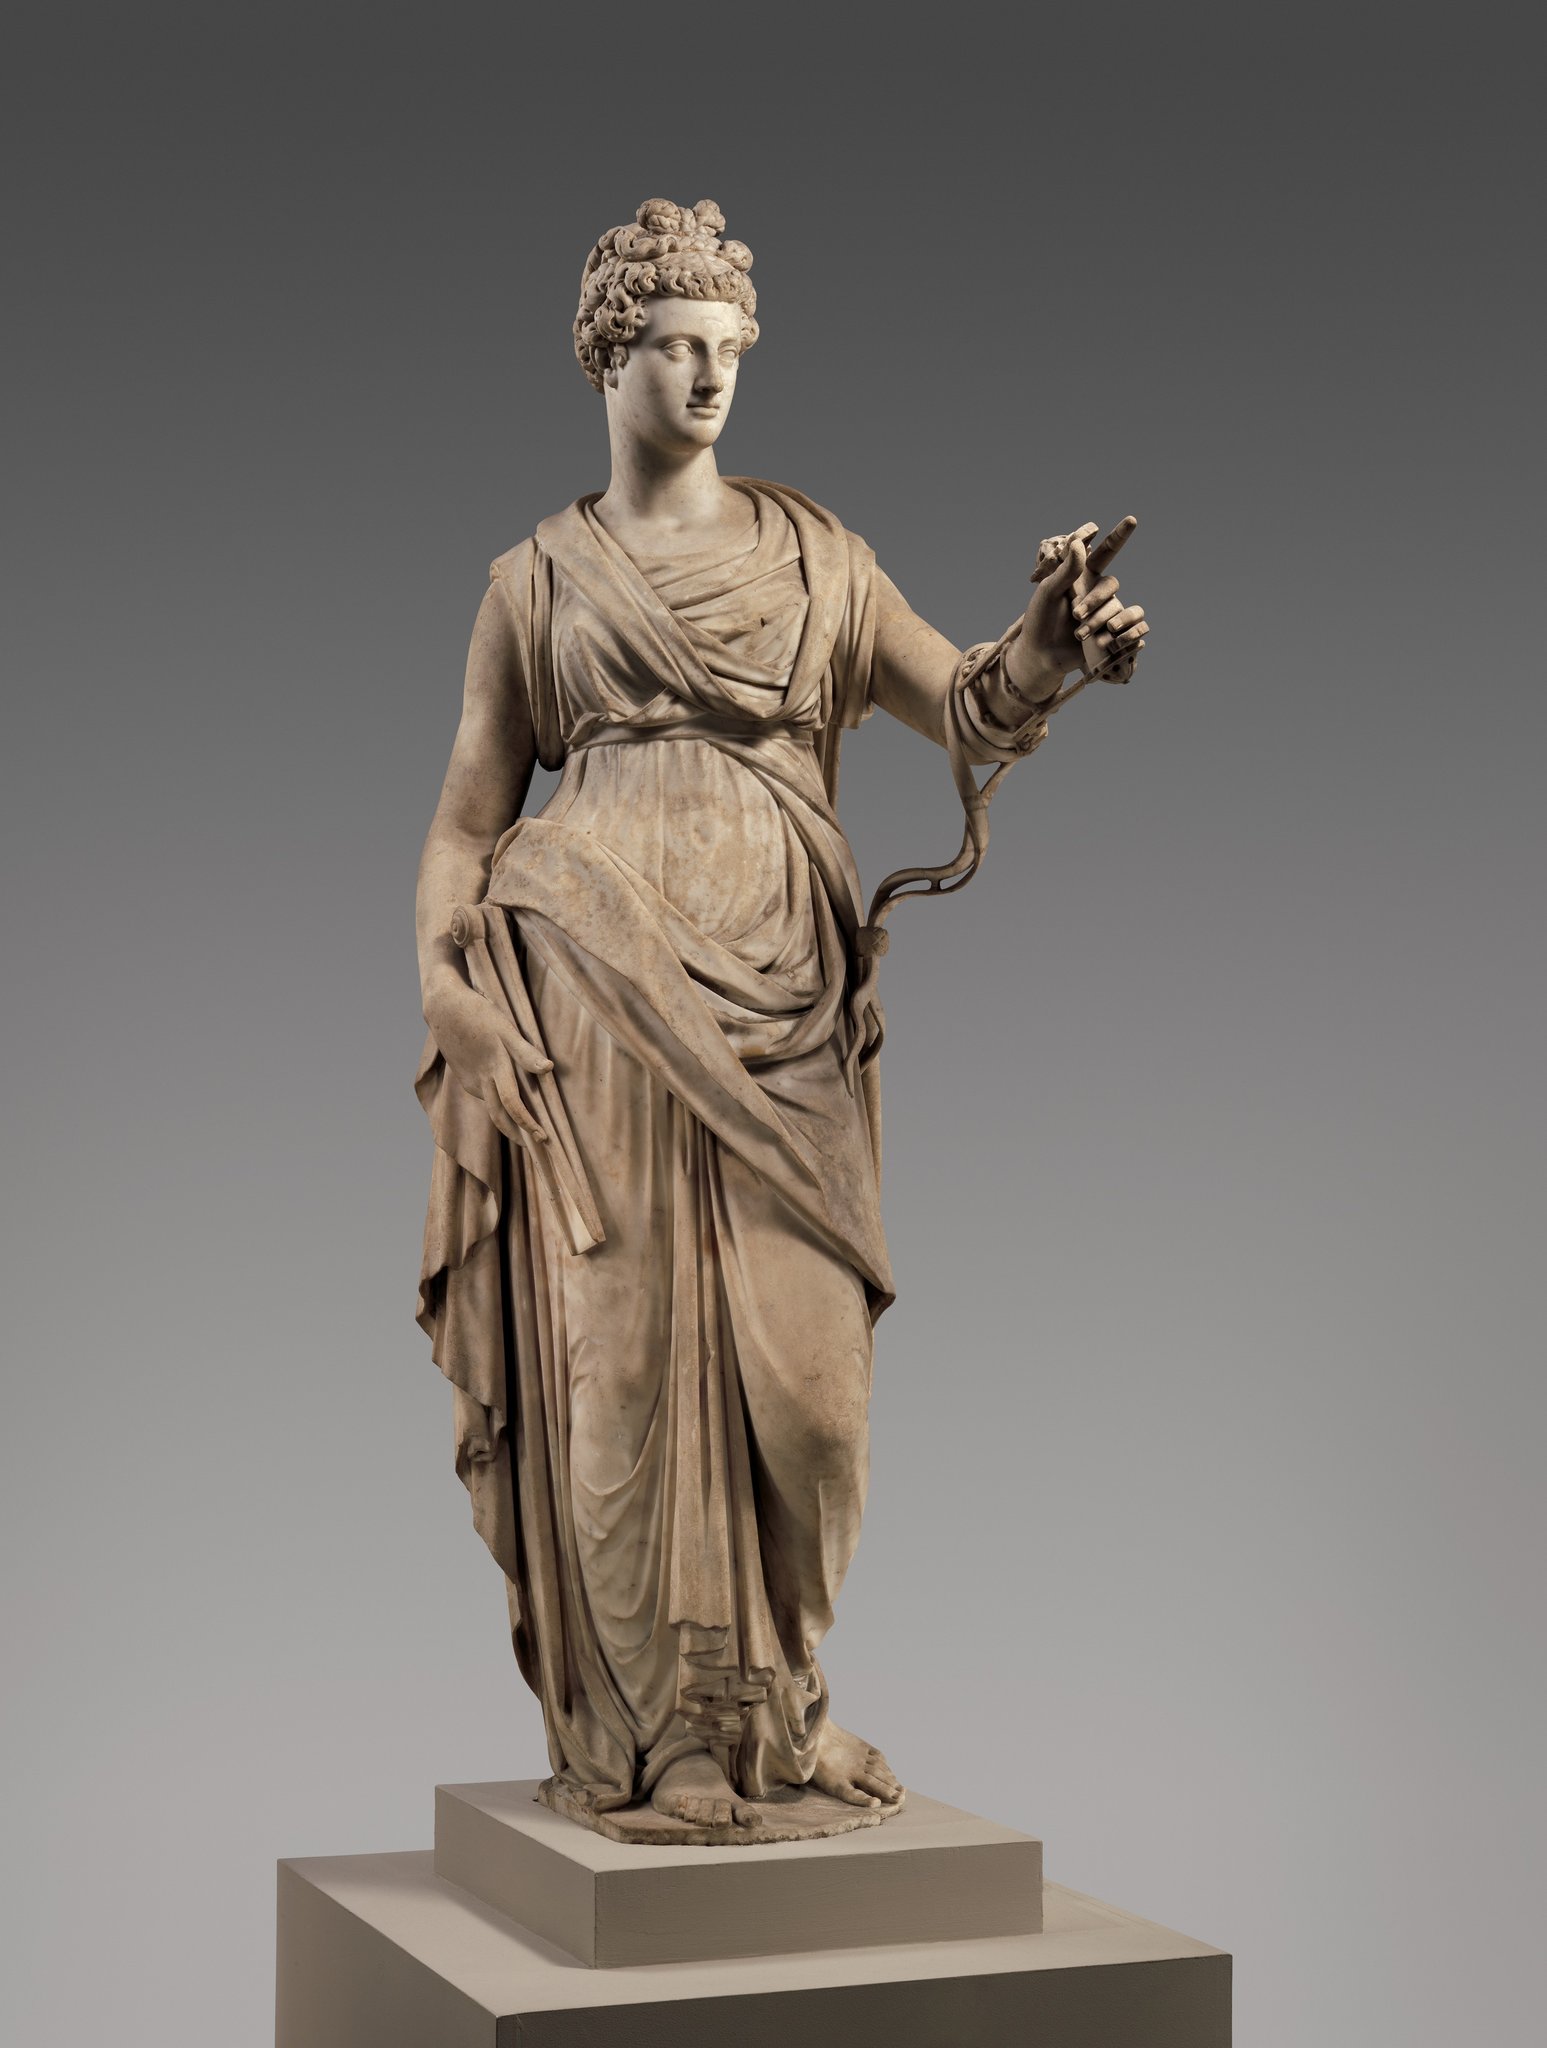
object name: statue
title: Temperance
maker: giovanni caccini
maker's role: artist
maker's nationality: italian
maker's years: 1556-1613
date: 1583-1584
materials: marble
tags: women